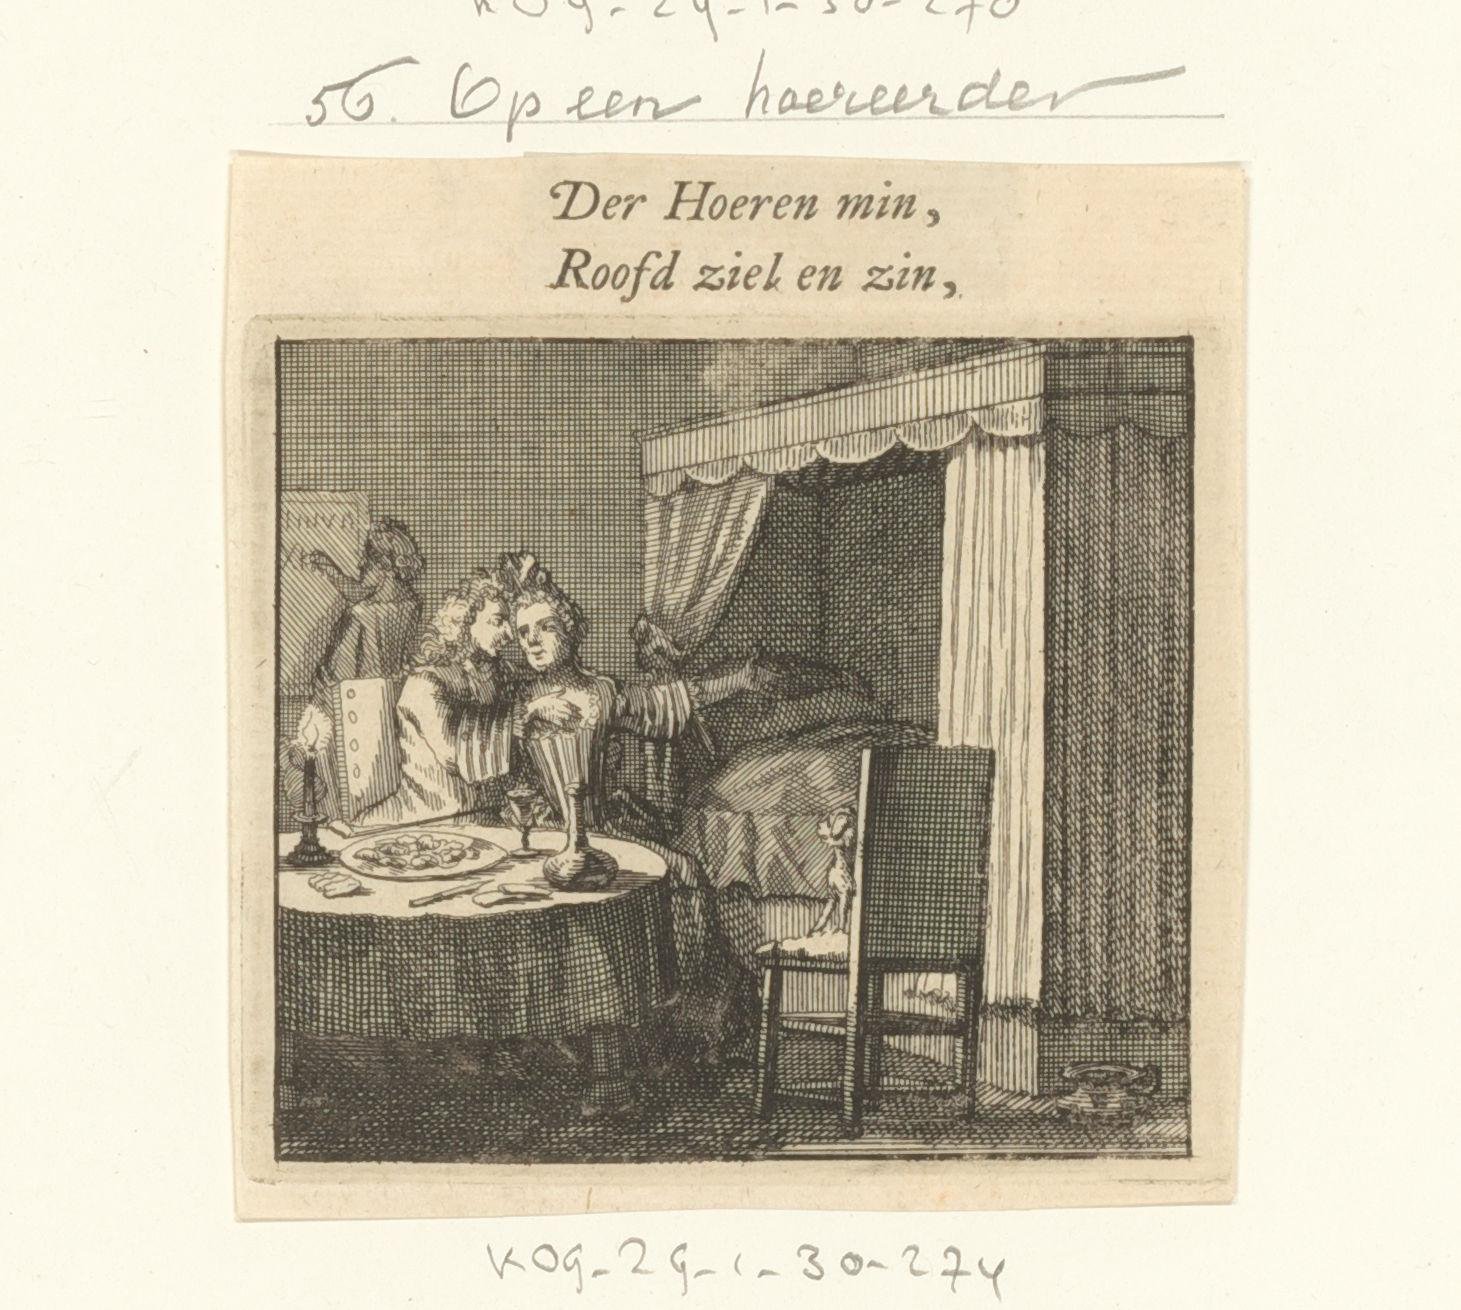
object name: print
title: Vrouw wijst naar een bed terwijl een man haar boezem betast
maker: cornelis huyberts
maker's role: print maker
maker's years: 1669-1709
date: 1725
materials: paper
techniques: etching, letterpress printing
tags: brothel, whore, prostitute, prostitution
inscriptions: stamp, collector's mark: Lugt 1641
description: Prent uit: Graauwhart, Hendrik. Voorbeeldelyke zeede-lessen, genoomen uyt den eersten toestand des werelds (...). Amsterdam: Johannes Ratelband, 1725. Prent ook gebruikt voor eerdere en (1709) latere uitgave (1756, 1761 en 1764).